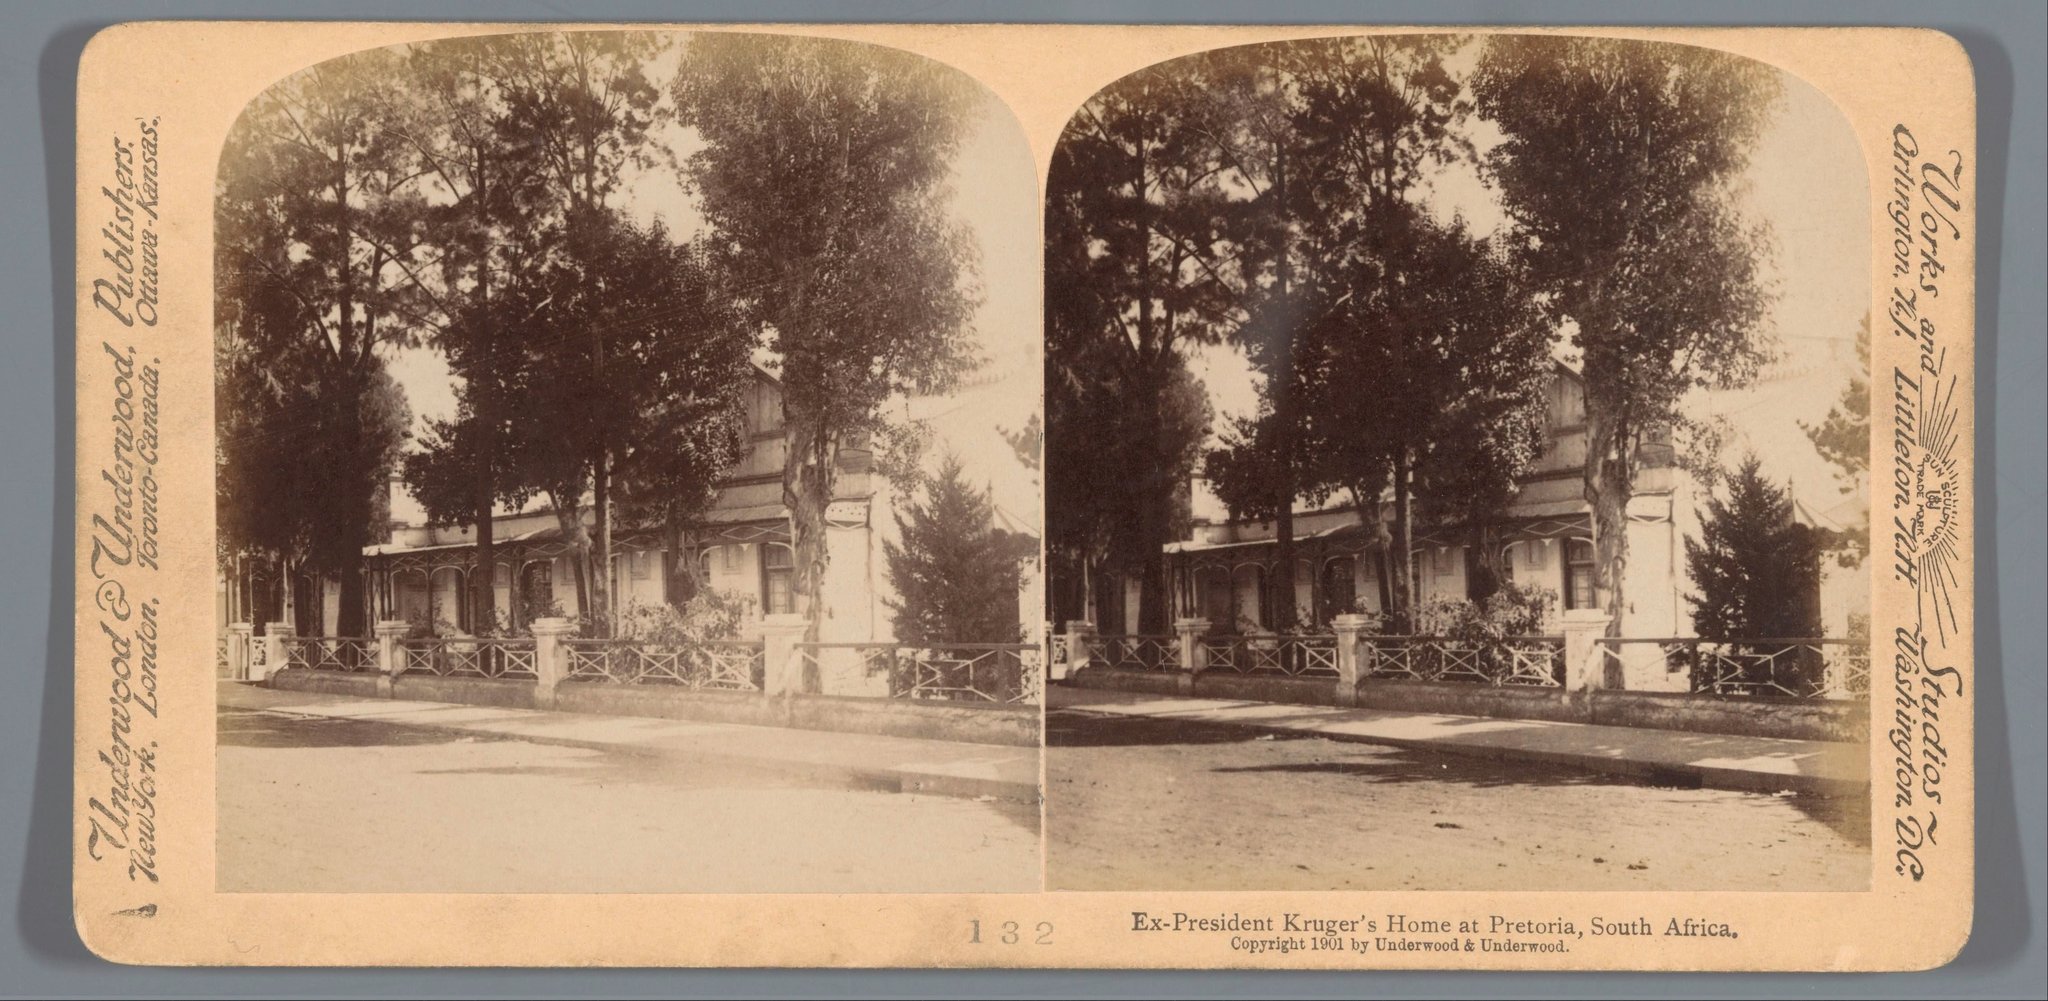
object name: stereograph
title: Ex-President Kruger's Home at Pretoria, South Africa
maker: Anonymous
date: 1901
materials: cardboard, paper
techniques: albumen print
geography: new york city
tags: villa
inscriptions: copyright notice: ‘Copyright 1901 by Underwood & Underwood.’, inscription, number: ‘132’, inscription: ‘Works and Studios ~/ Arlington, N.J. Littleton, N.H. Washington, D.C.’